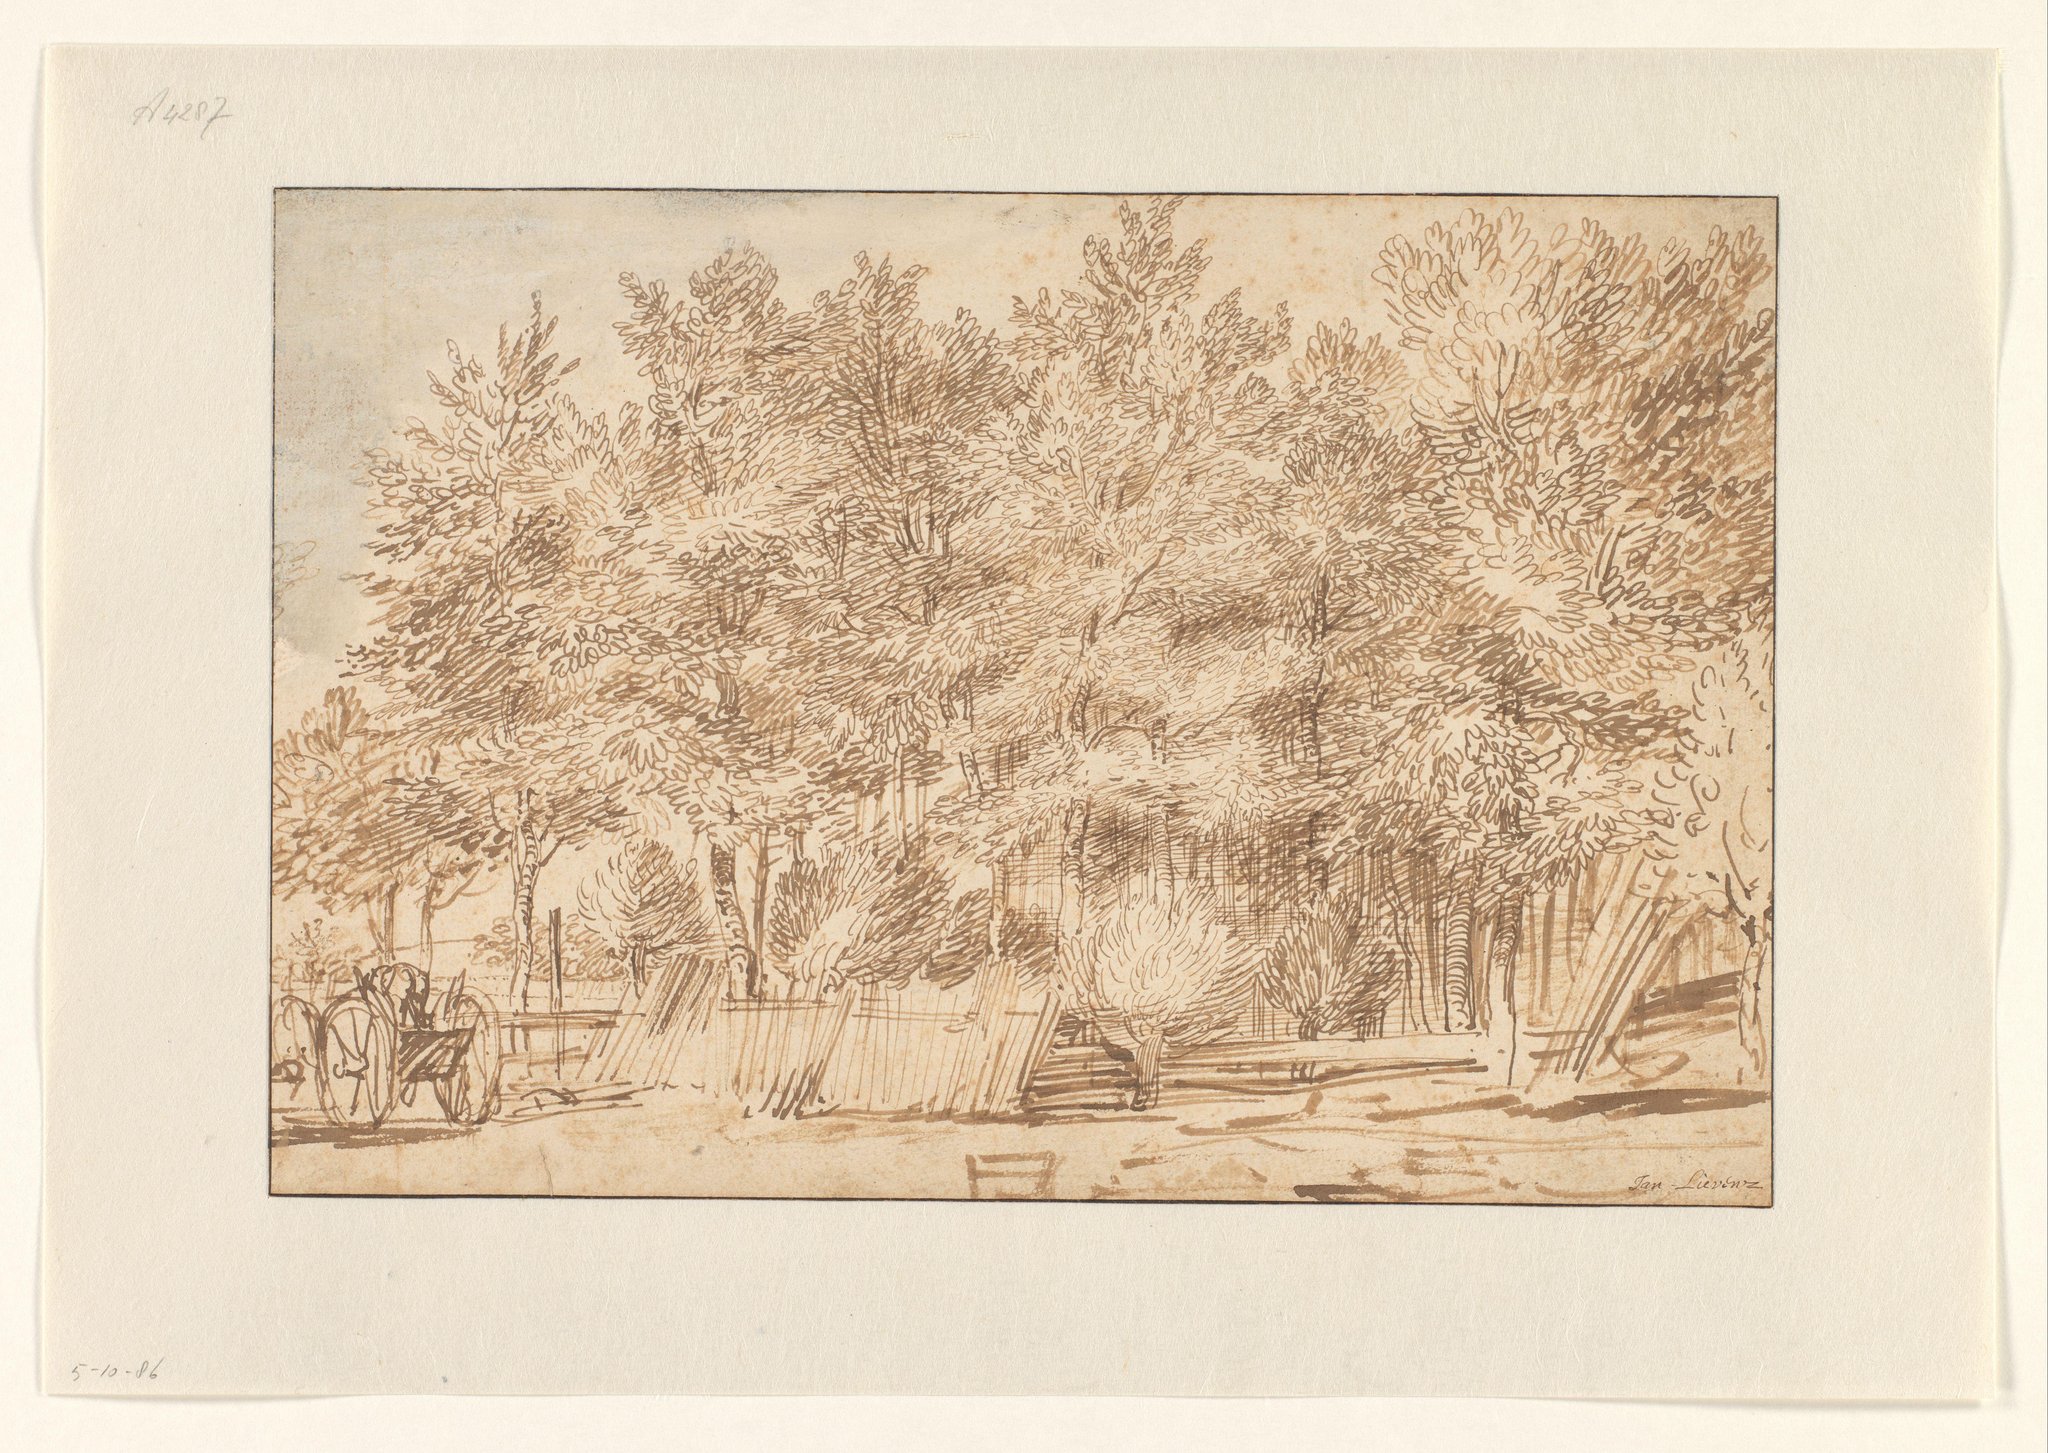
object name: drawing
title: Bosrand met schutting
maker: jan lievens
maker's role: draughtsman, painter, print maker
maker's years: 1607-1674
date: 1650-1669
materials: ink, paper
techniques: pen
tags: forest, wood